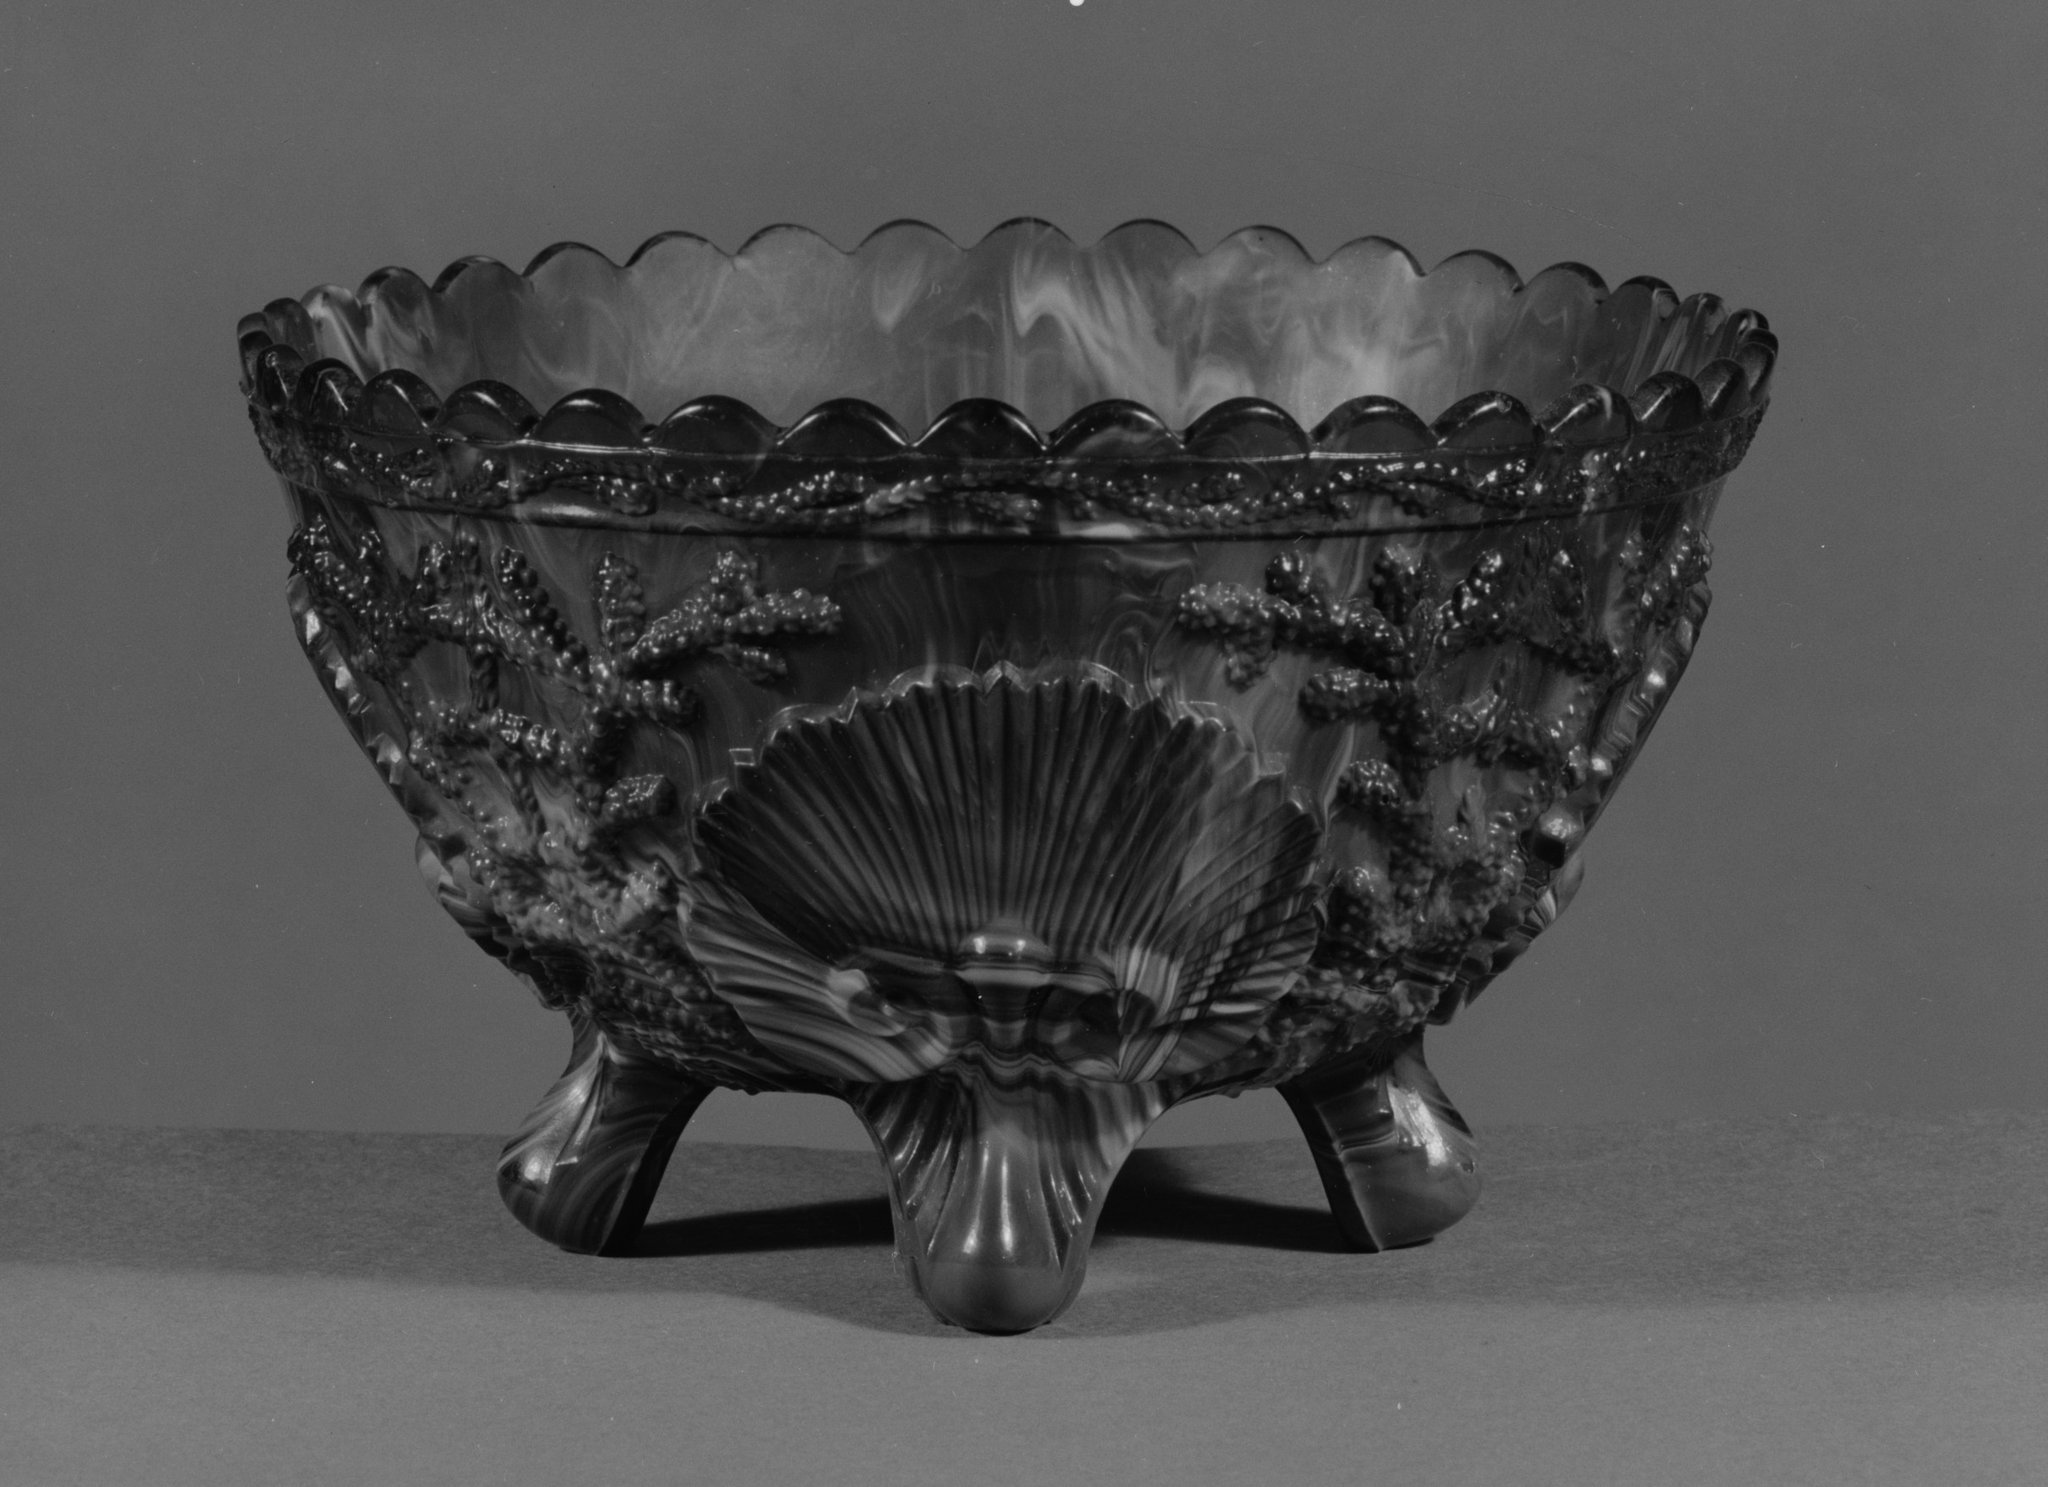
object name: bowl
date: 1880-1890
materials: glass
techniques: pressed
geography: england